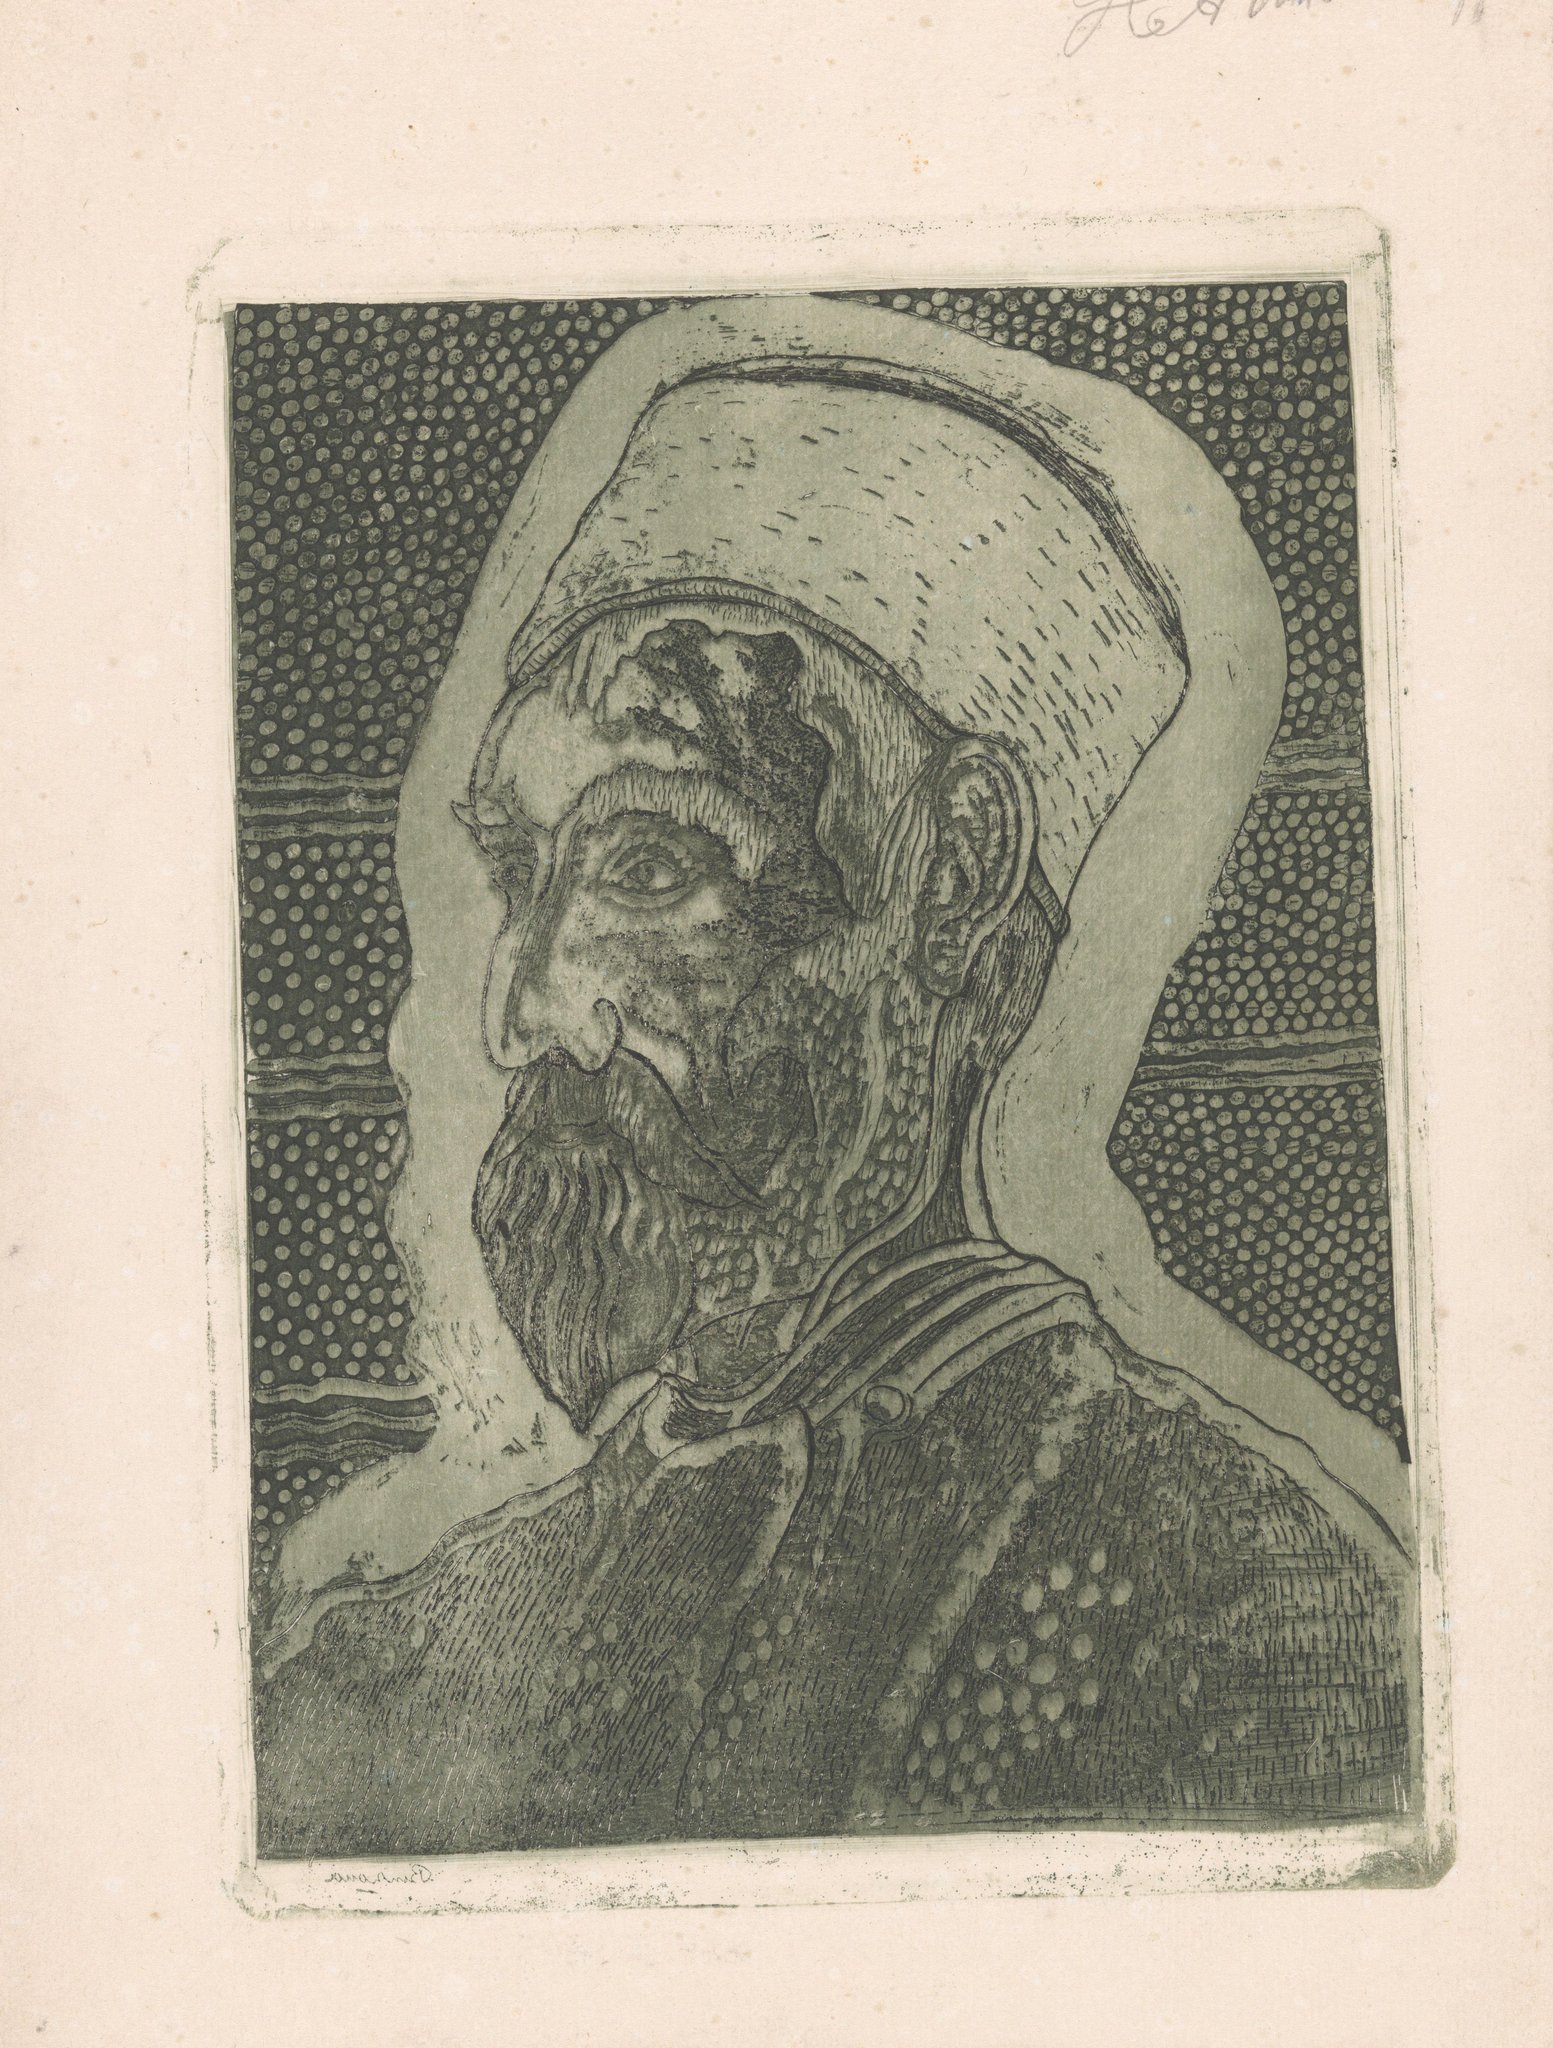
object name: print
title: Oude Marokkaan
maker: herman antonius van daalhoff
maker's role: draughtsman, print maker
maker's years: 1867-1953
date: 1877-1953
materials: paper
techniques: etching, intaglio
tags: head-gear, anonymous historical person portrayed alone, beard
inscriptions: collector's mark: Lugt 2228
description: De man heeft een baard en draagt een fez.